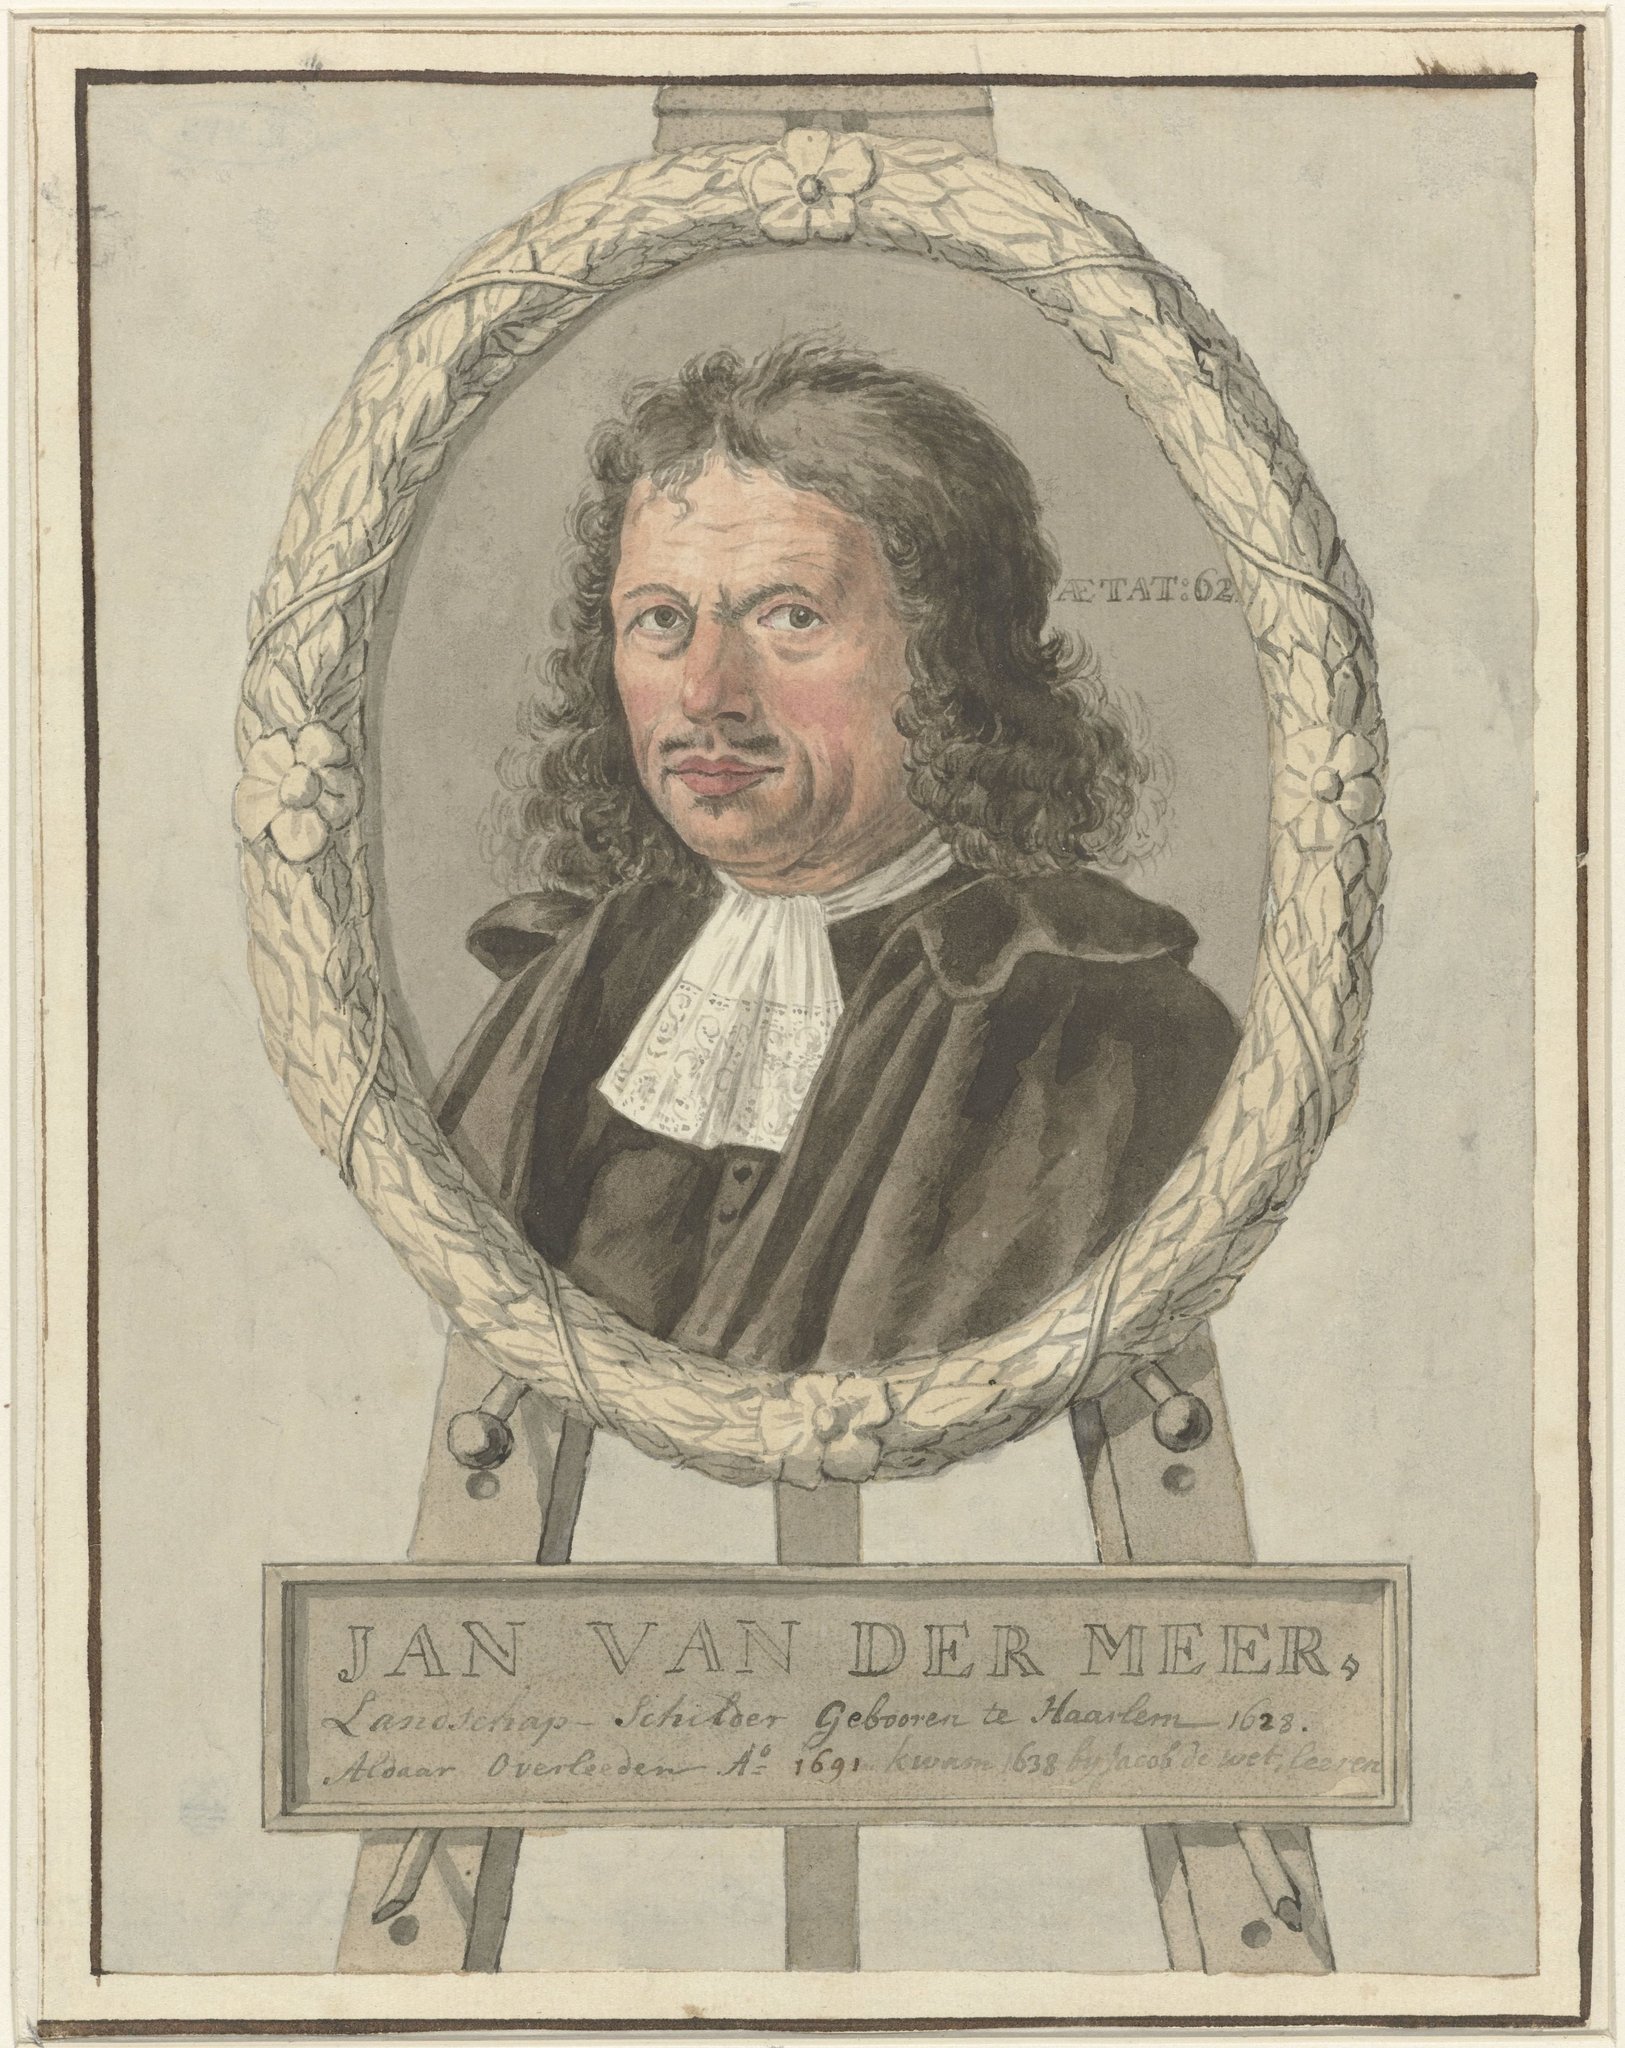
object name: drawing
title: Portret van Johannes van der Meer de Oude, in lauwerkrans op schildersezel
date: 1712-1795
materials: ink, paper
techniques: brush, pen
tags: painter, jan vermeer van haarlem (i), historical persons, portrait, self-portrait of artist